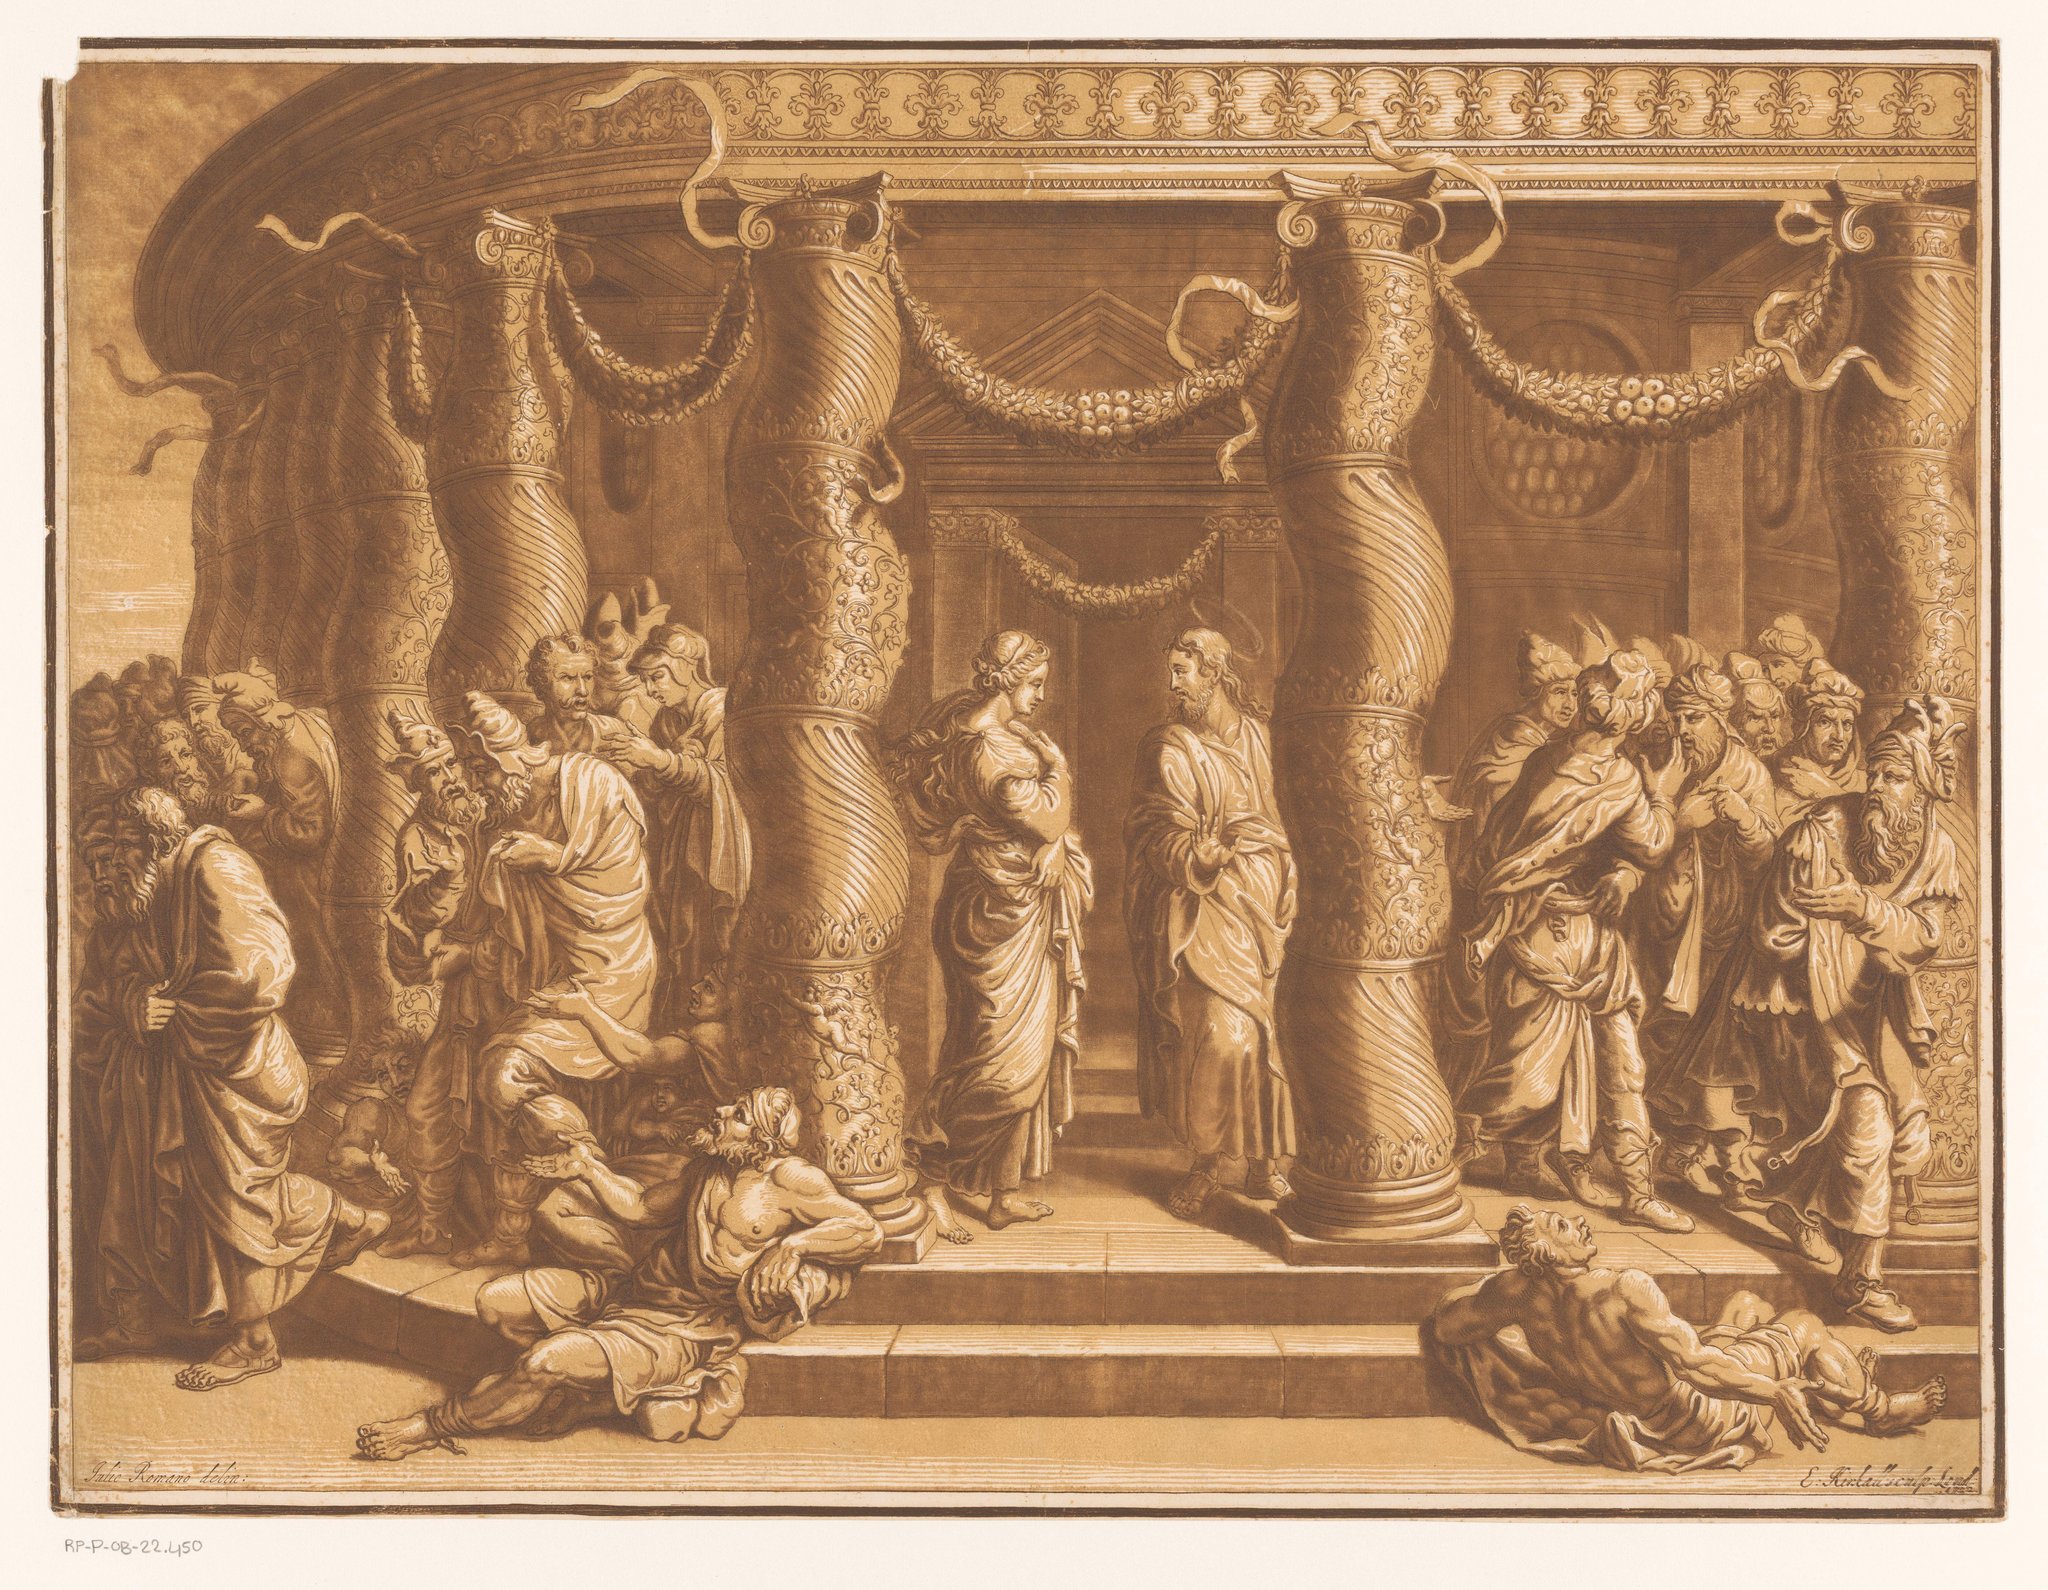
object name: print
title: Christus en de overspelige vrouw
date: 1722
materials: paper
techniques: woodcut, etching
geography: london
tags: pharisees bring a woman accused of adultery before christ (john 8:2-11)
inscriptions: collector's mark: Lugt 240